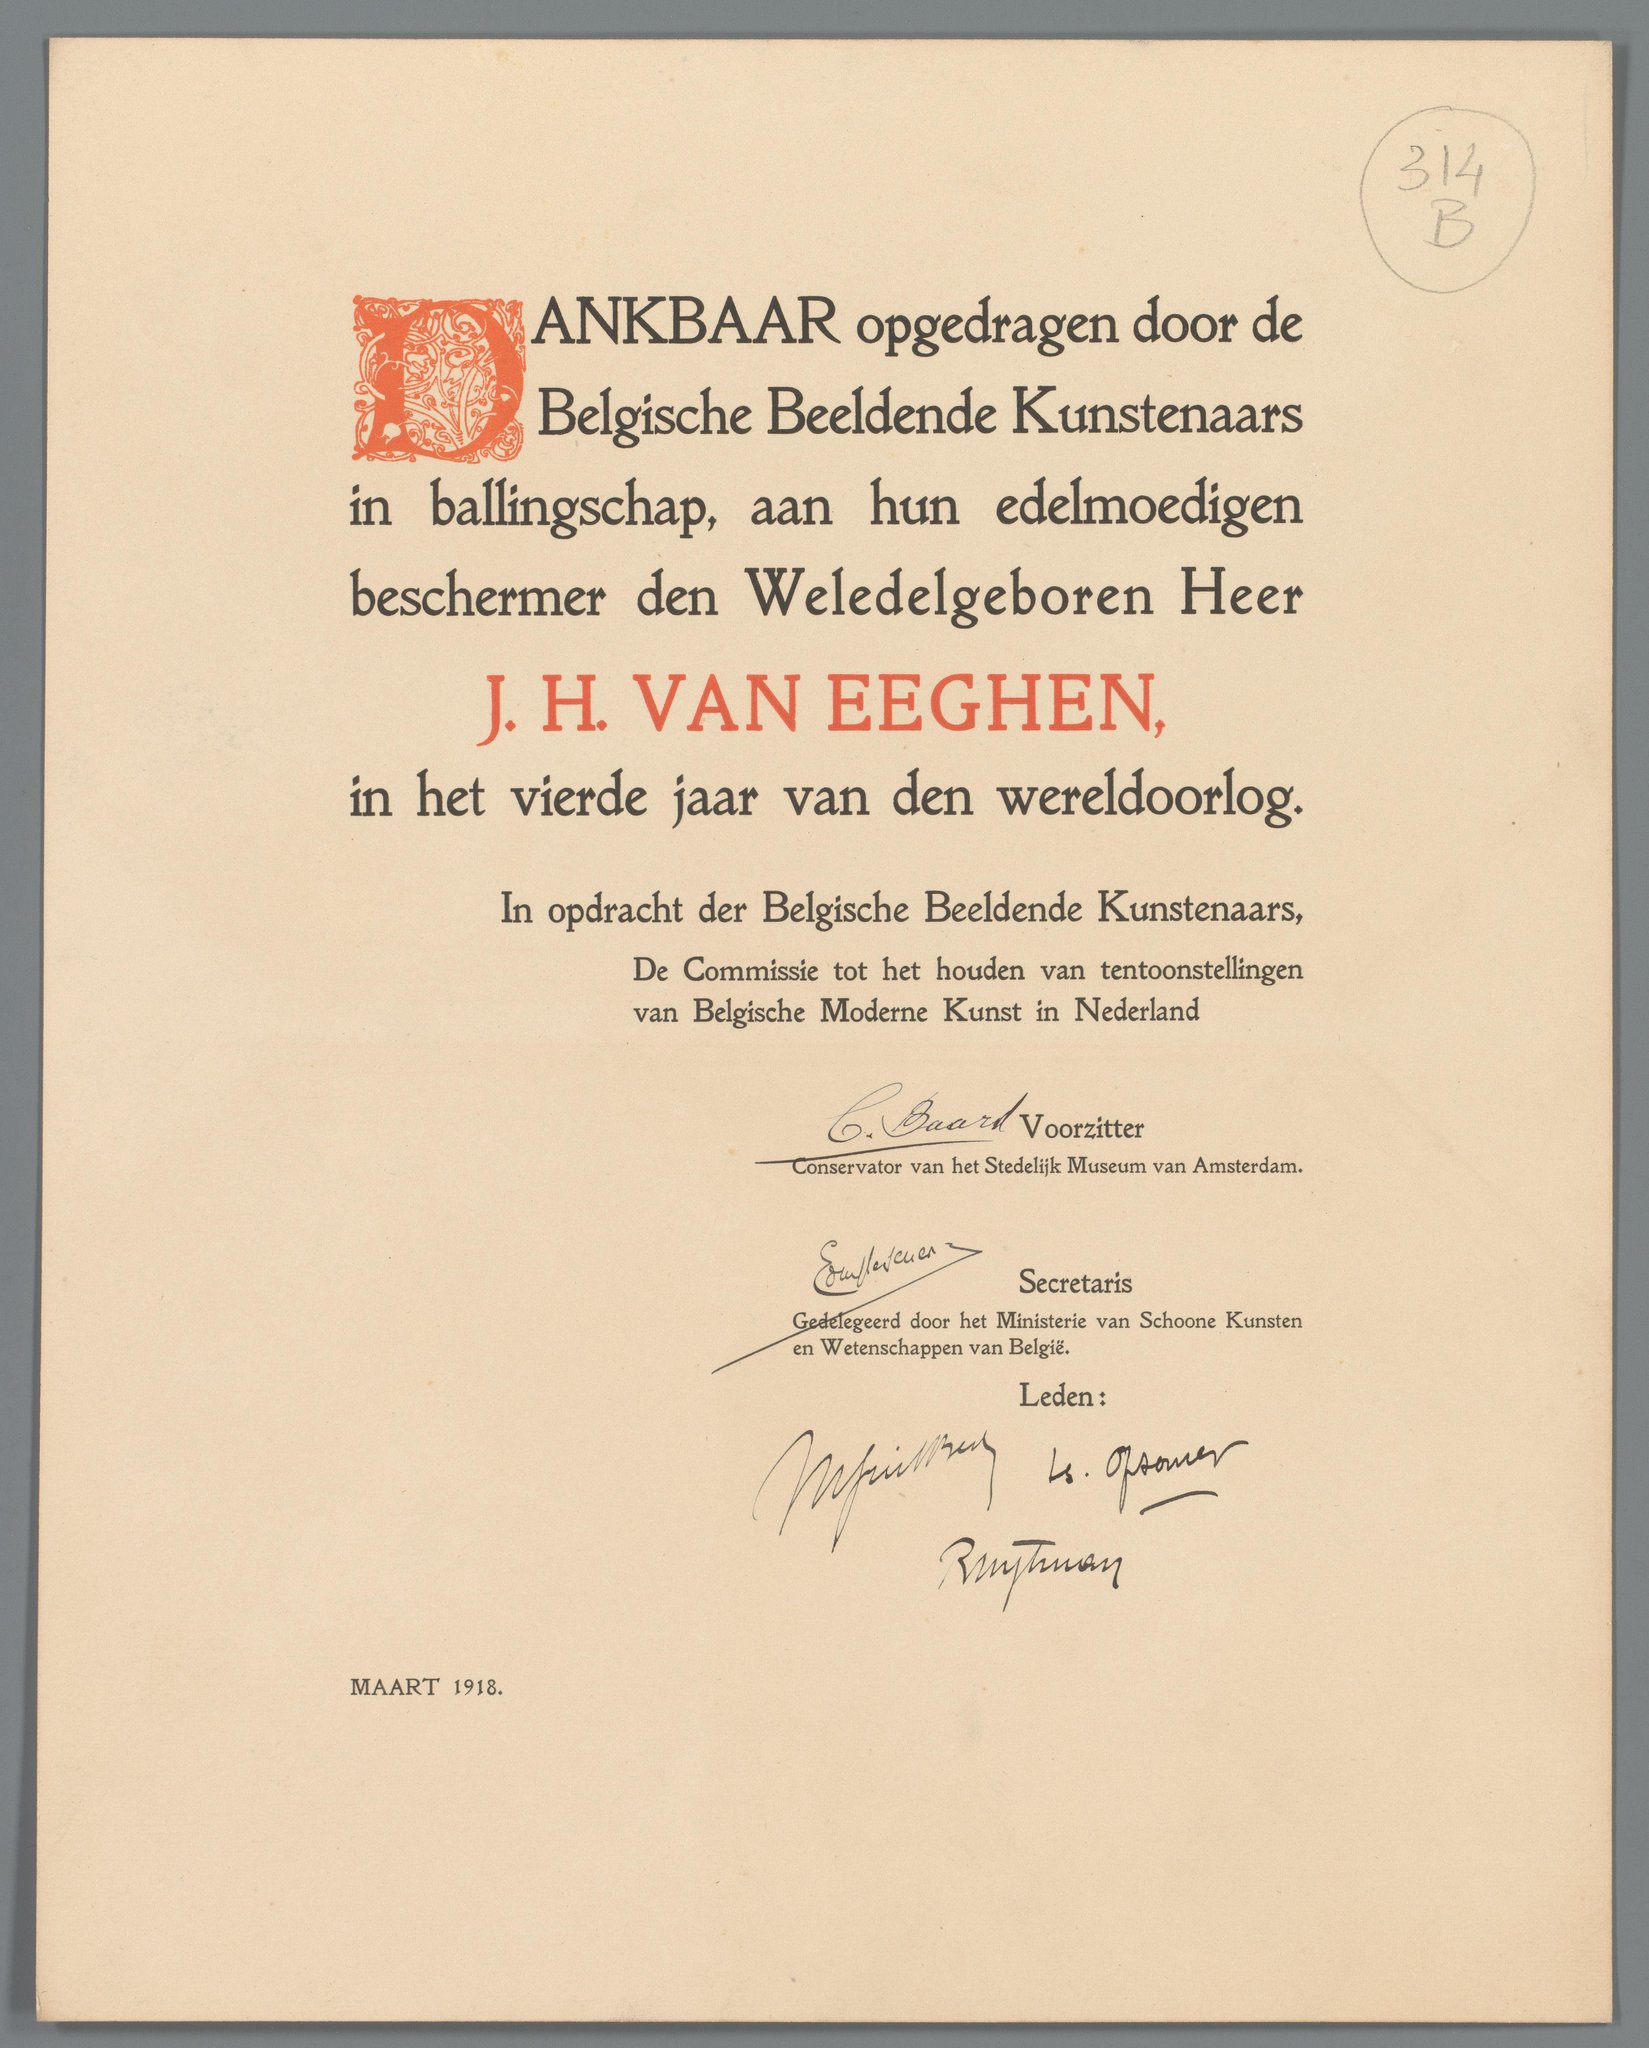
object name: text sheet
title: Dankbaar opgedragen door de Belgische Beeldende Kunstenaars in ballingschap, aan hun edelmoedigen beschermer den Weledelgeboren Heer J.H. van Eeghen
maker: cornelis wilhelmus hyginus baard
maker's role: conservator, museumdirecteur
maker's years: 1870-1946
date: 1903-1918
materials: paper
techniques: letterpress printing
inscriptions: signature